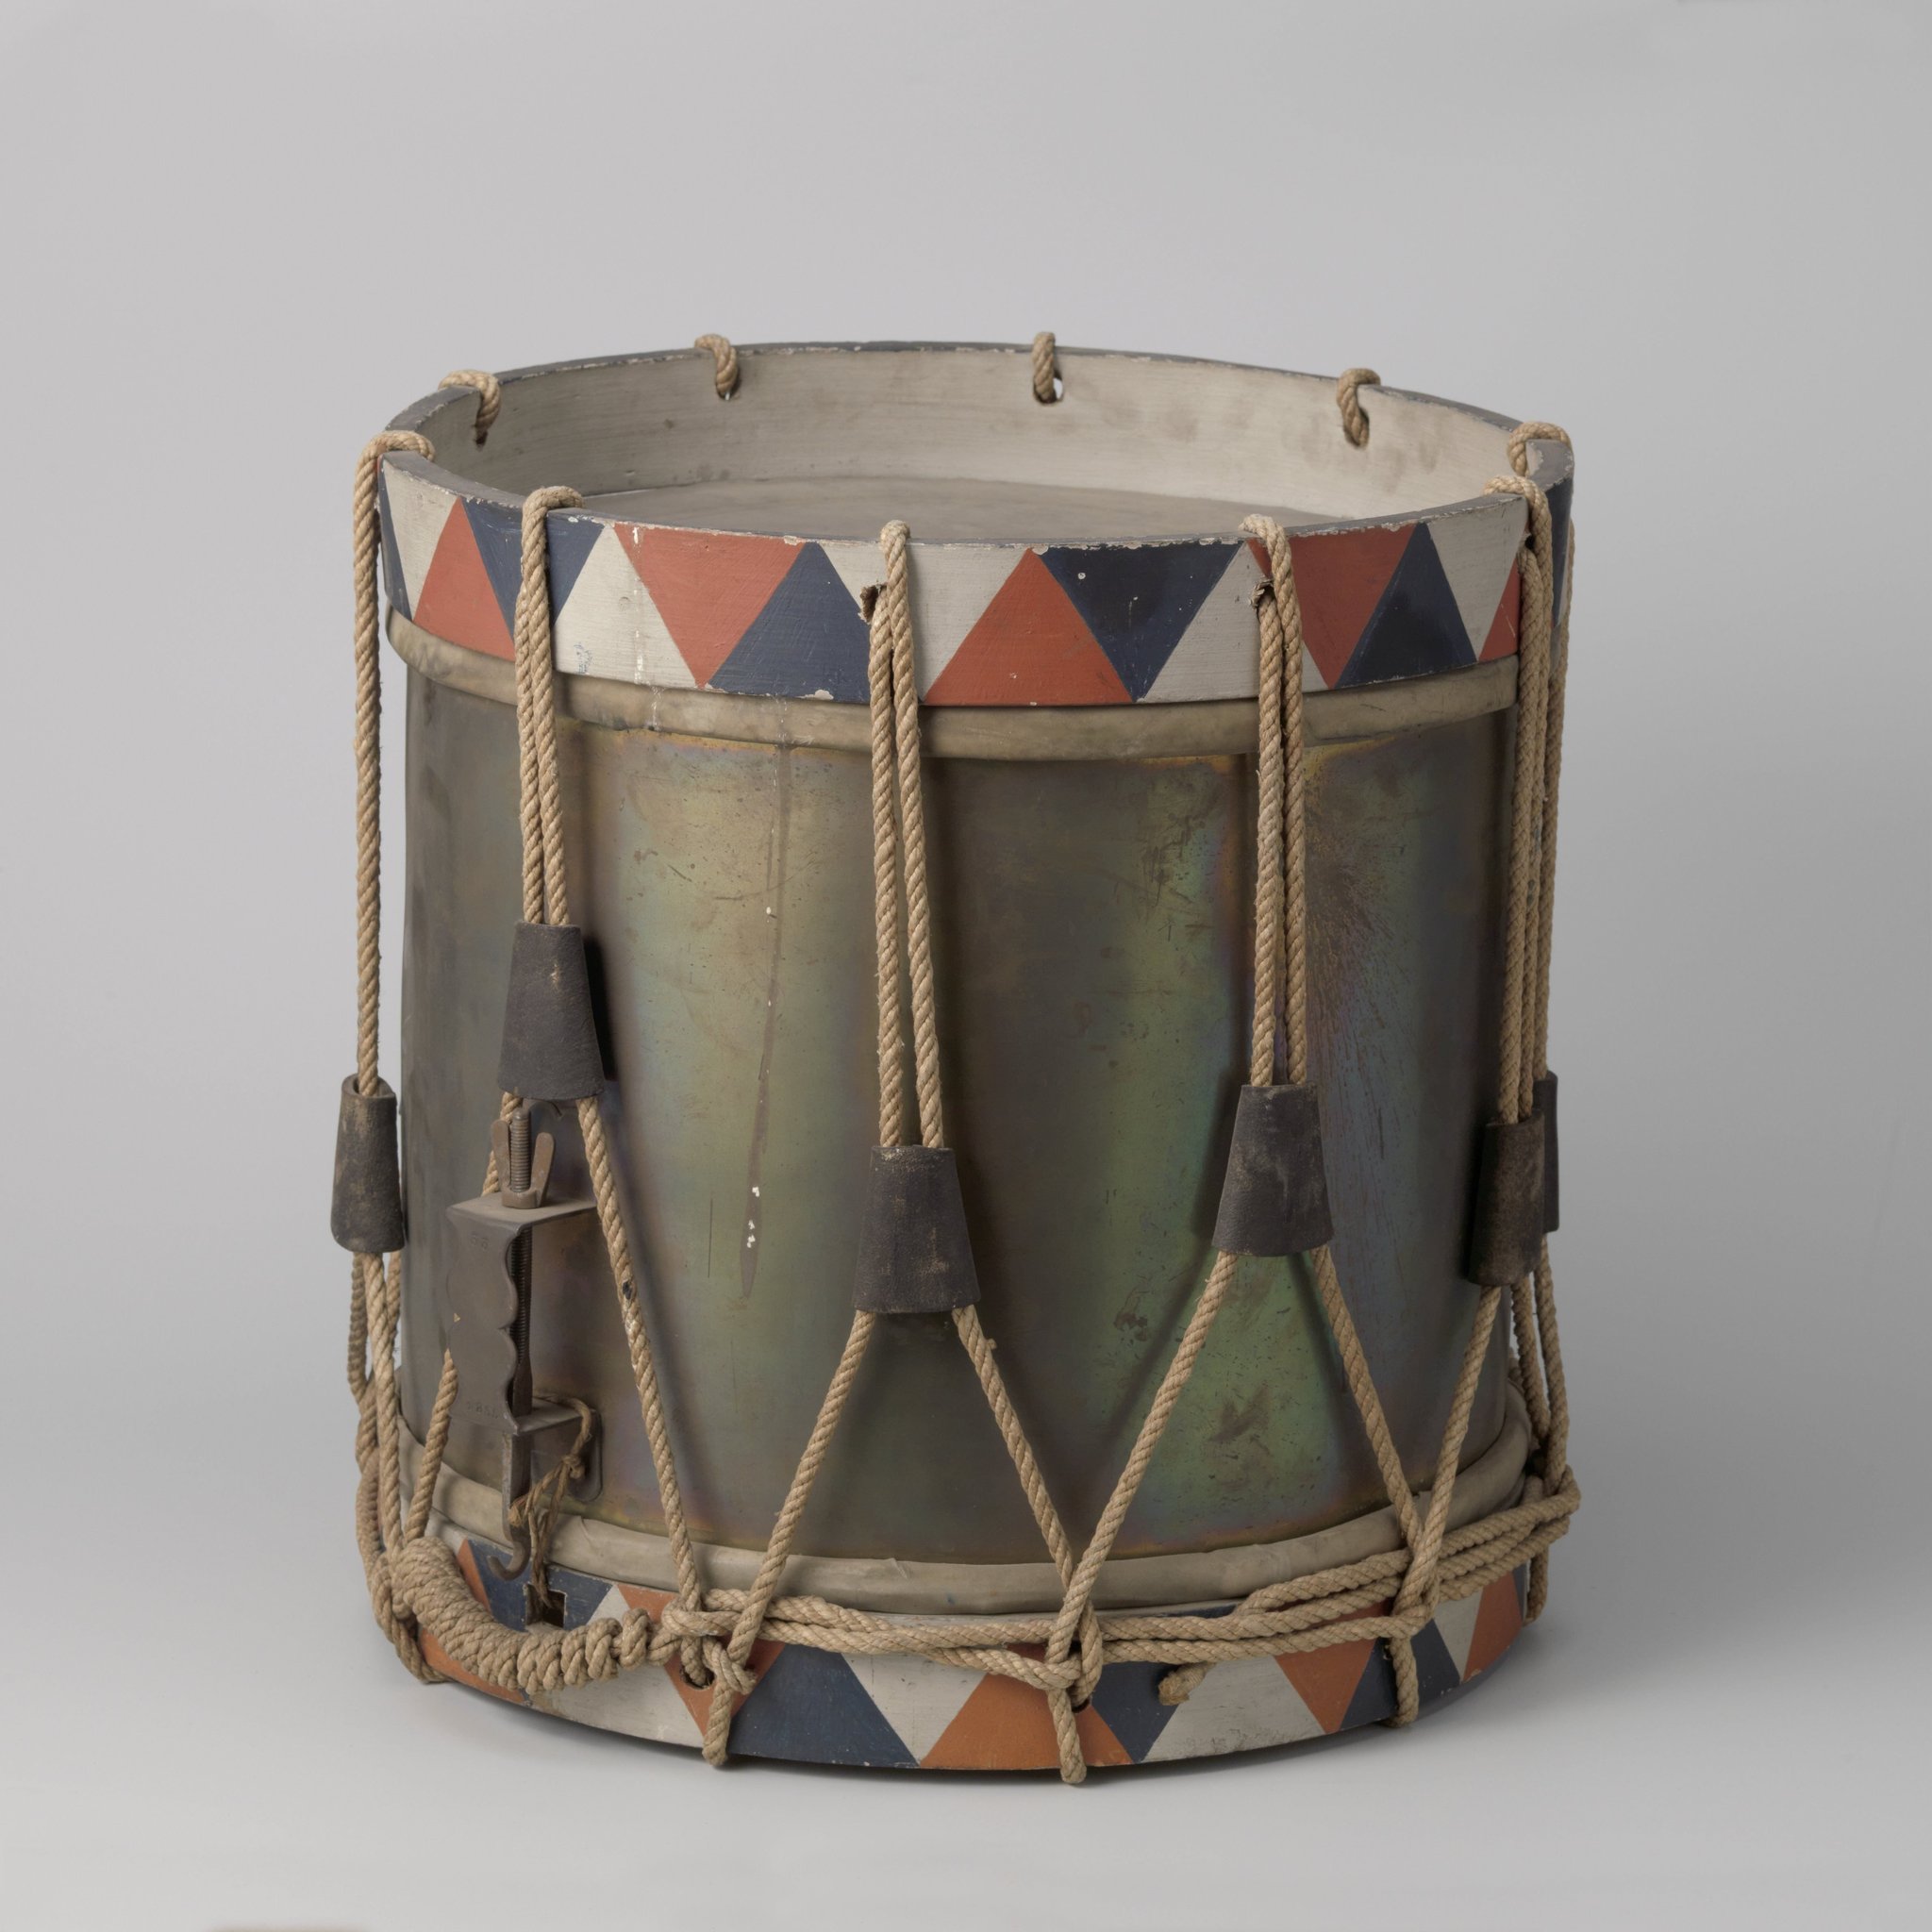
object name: percussion instrument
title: Trommels (39 x)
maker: Anonymous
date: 1855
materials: brass, fiber, skin, wood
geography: netherlands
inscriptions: inscription: ‘1855-33’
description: Music has always been a crucial element of public celebrations, such as military parades, coronations, royal weddings, and funerals, adding grandeur to the solemnity of the occasion. Musical ensembles entrusted with performing music at these events have existed in Europe since the Middle Ages. This display highlights various marching bands and their musical instruments dating from the 16th to the 19th century.